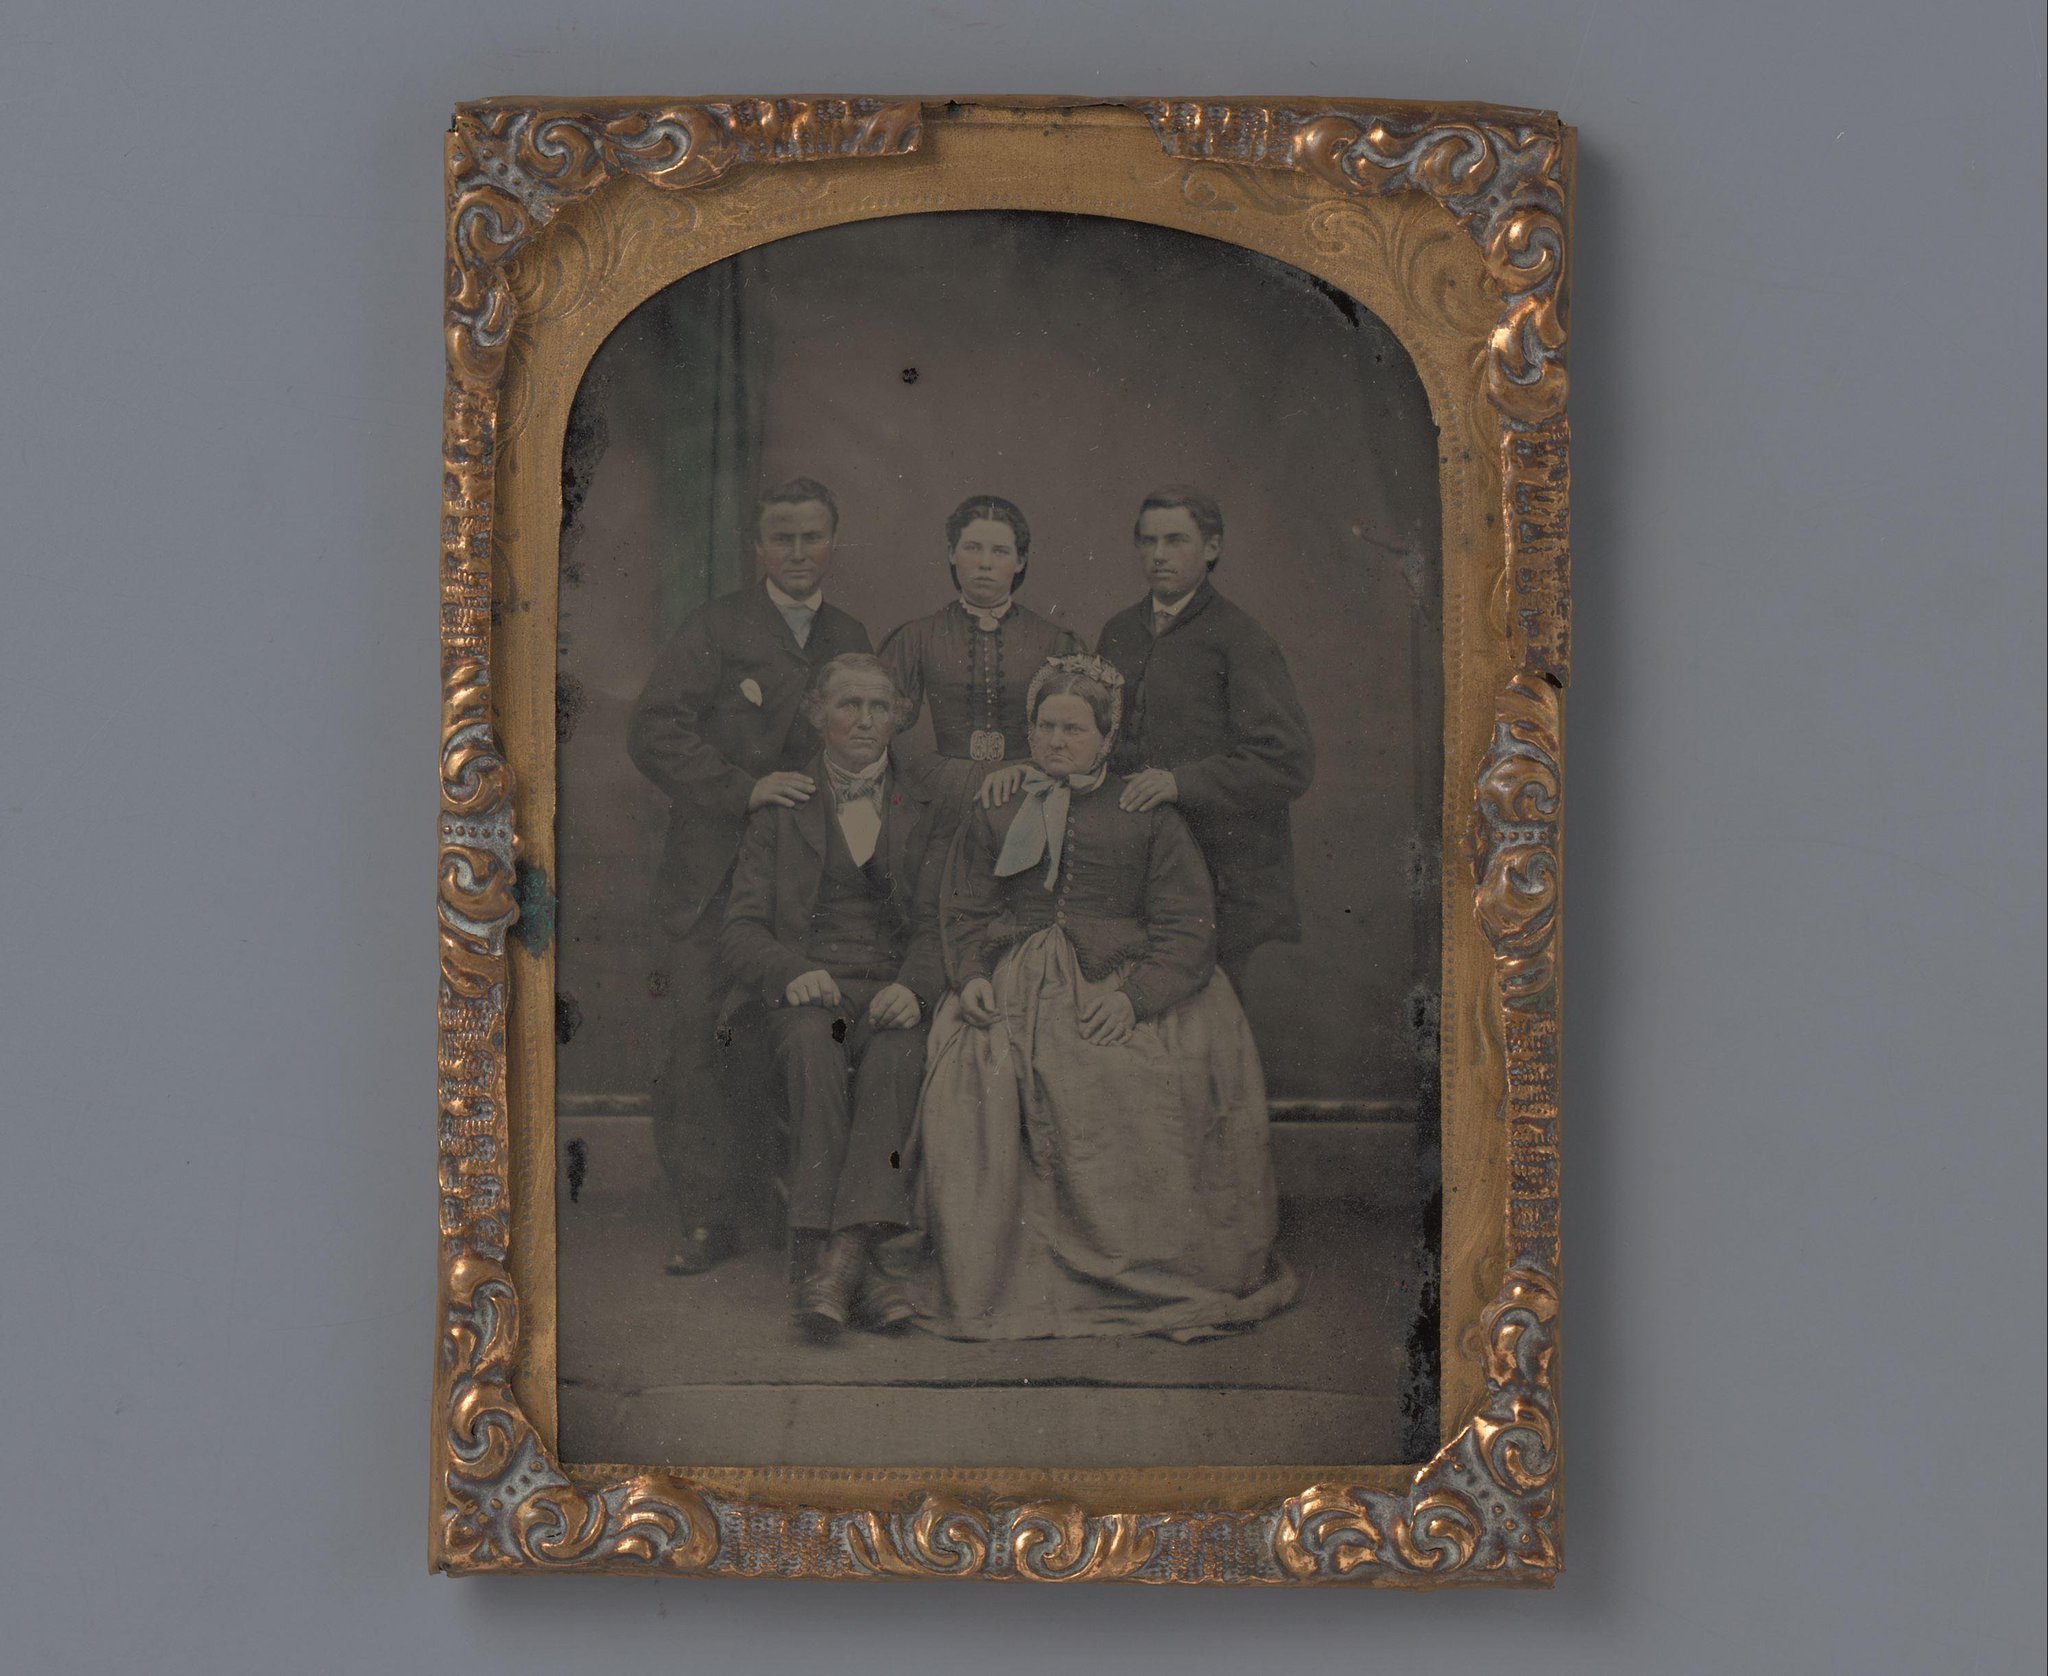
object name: photograph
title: Portret van een echtpaar en twee zonen en een dochter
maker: Anonymous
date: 1855-1870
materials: glass, metal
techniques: ambrotype, hand coloring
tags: adult woman, parents with their children, adult man, anonymous historical persons portrayed in a group, in a group-portrait